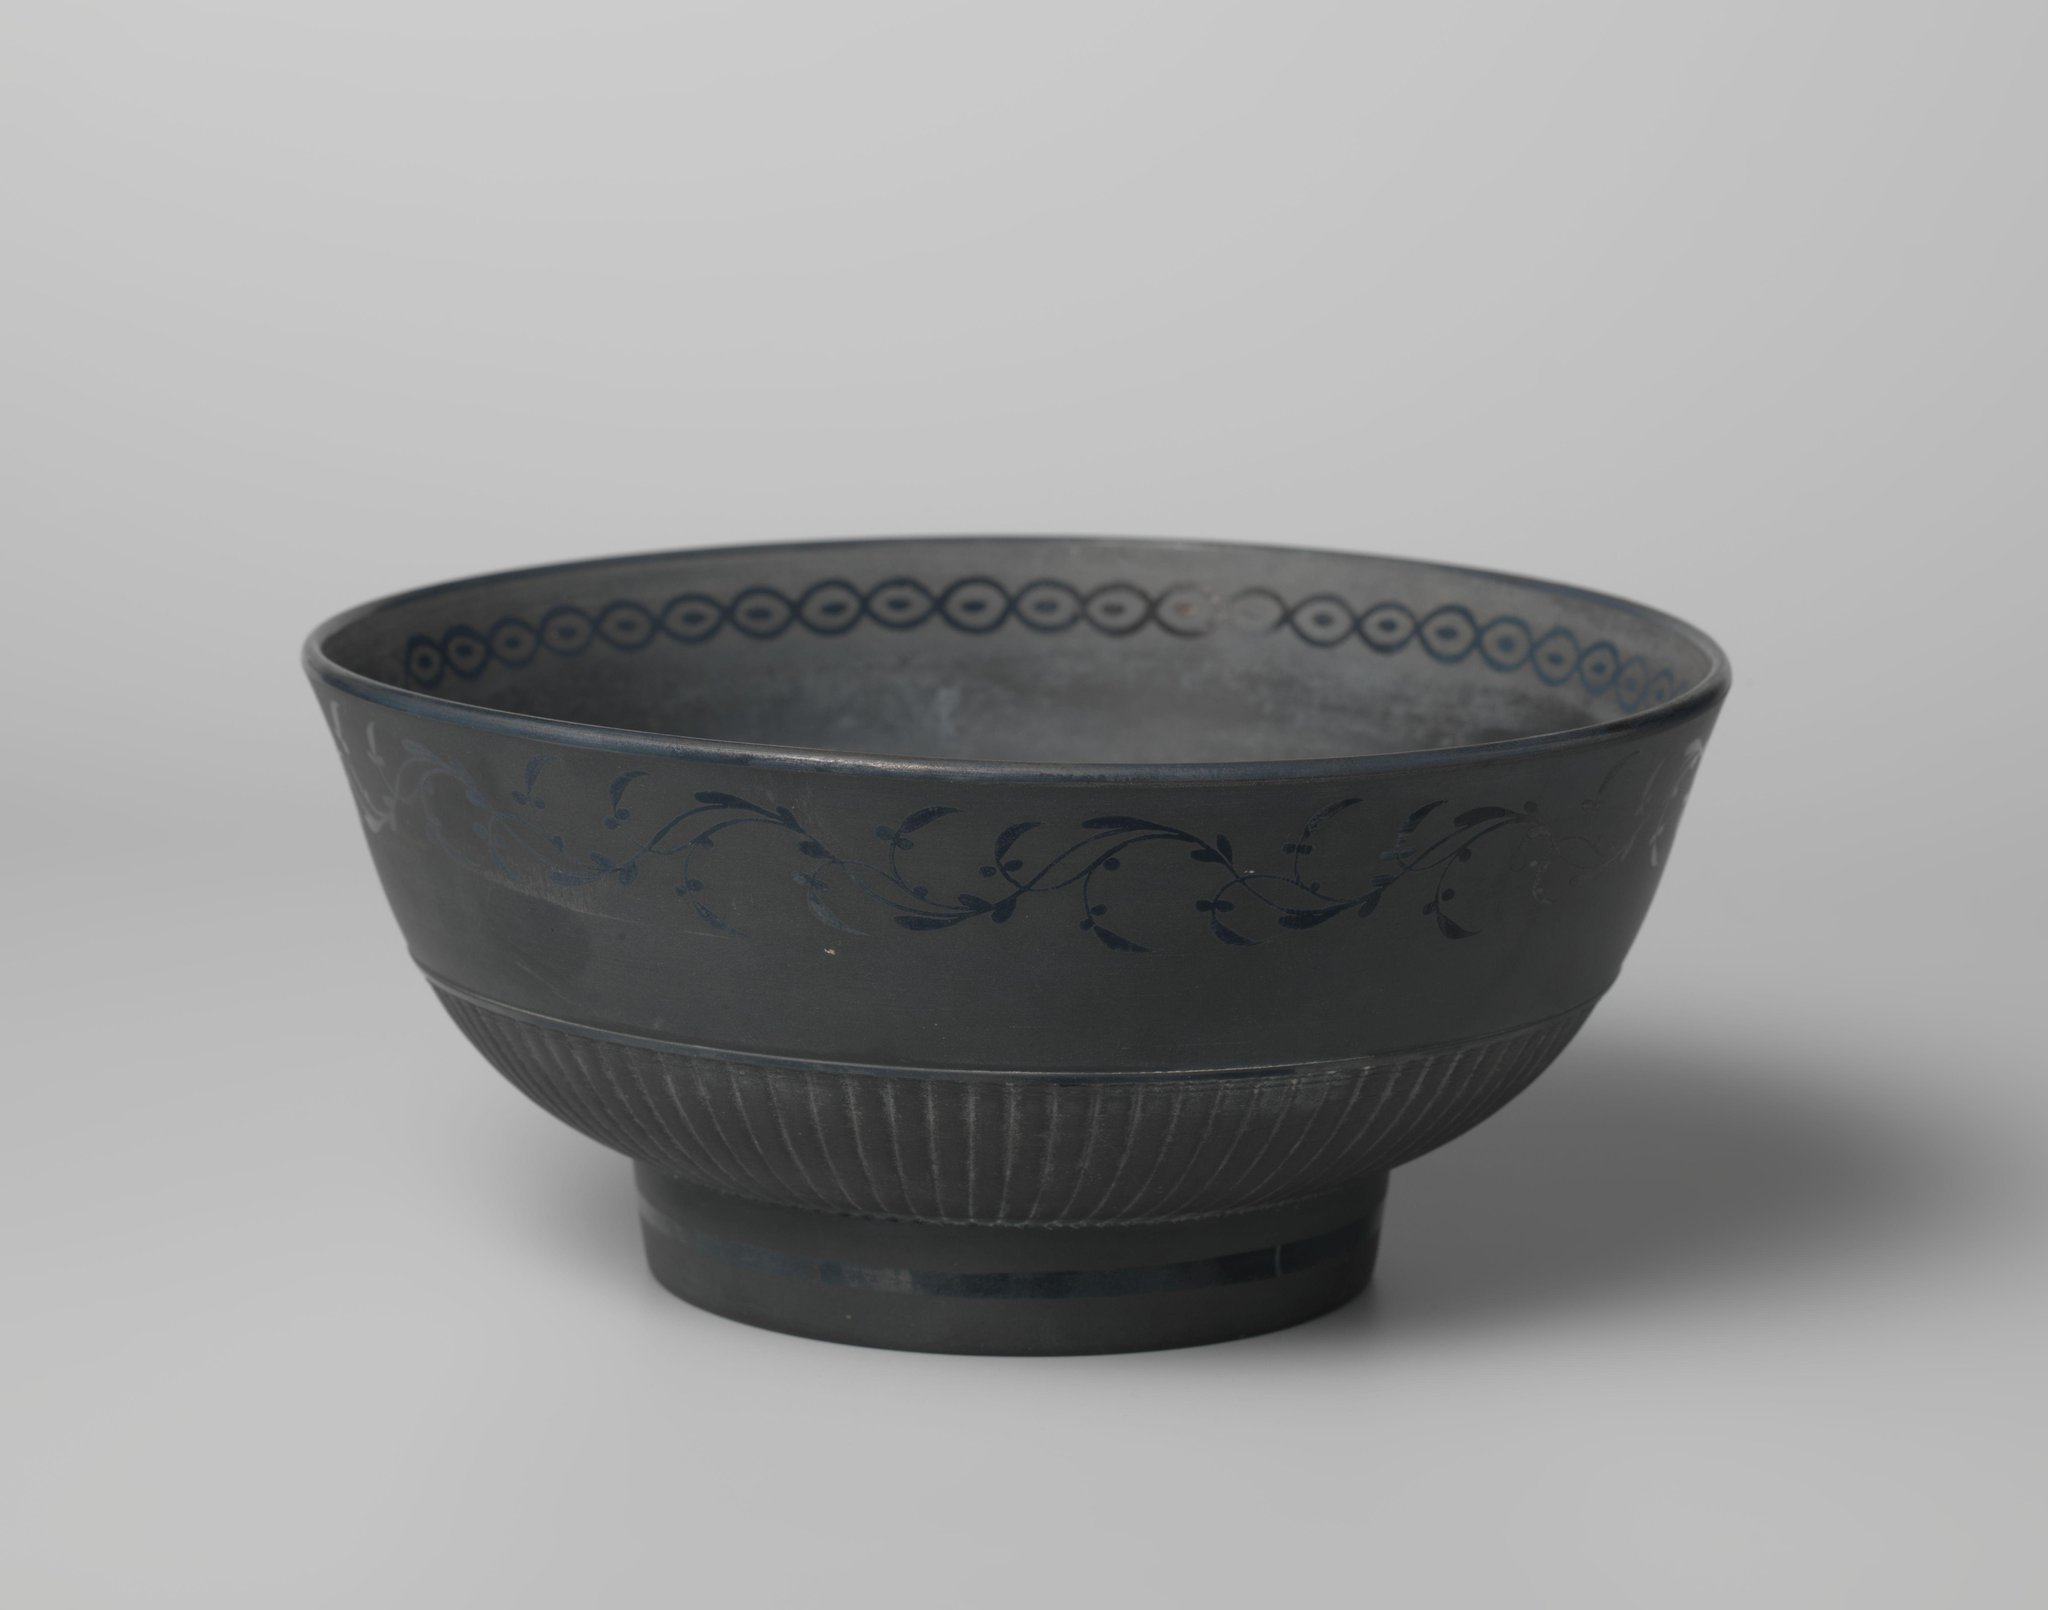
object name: bowl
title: Spoelkom van aardewerk, Neale & Palmer Black Basalt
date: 1790-1825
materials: earthenware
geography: hanley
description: Halfbolvormige spoelkom van aardewerk, Black Basalt. De kom heeft een standring. De onderste helft van de kom is geribd, langs de bovenrand loopt een zilverkleurige bladrank. Aan de binnenzijde loopt langs de bovenrand een geometrische band.